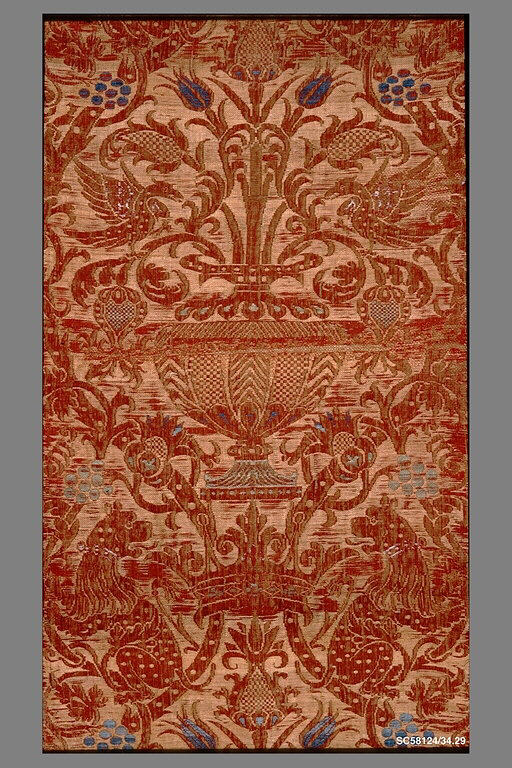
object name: panel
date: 1501-1600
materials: hemp, silk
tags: lions,flowers